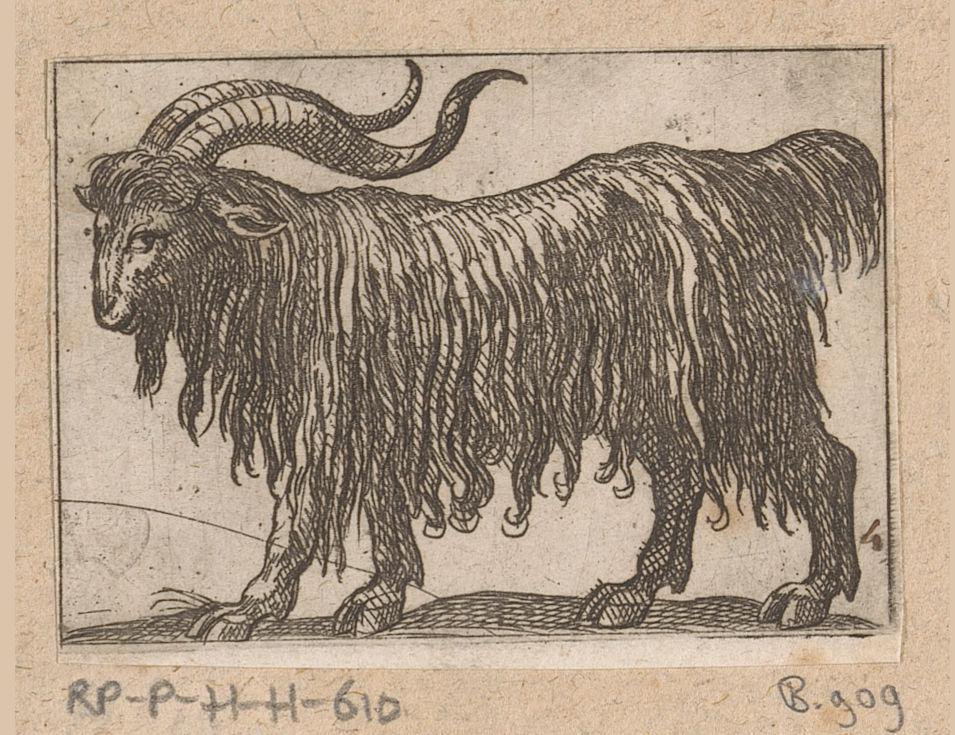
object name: print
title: Staande berggeit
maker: antonio tempesta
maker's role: draughtsman, painter, print maker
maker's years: 1555-1630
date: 1565-1630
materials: paper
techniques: etching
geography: italy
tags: goat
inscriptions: number: ‘4’, collector's mark: Lugt 11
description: Deze prent maakt deel uit van een reeks van 28 prenten van dieren.